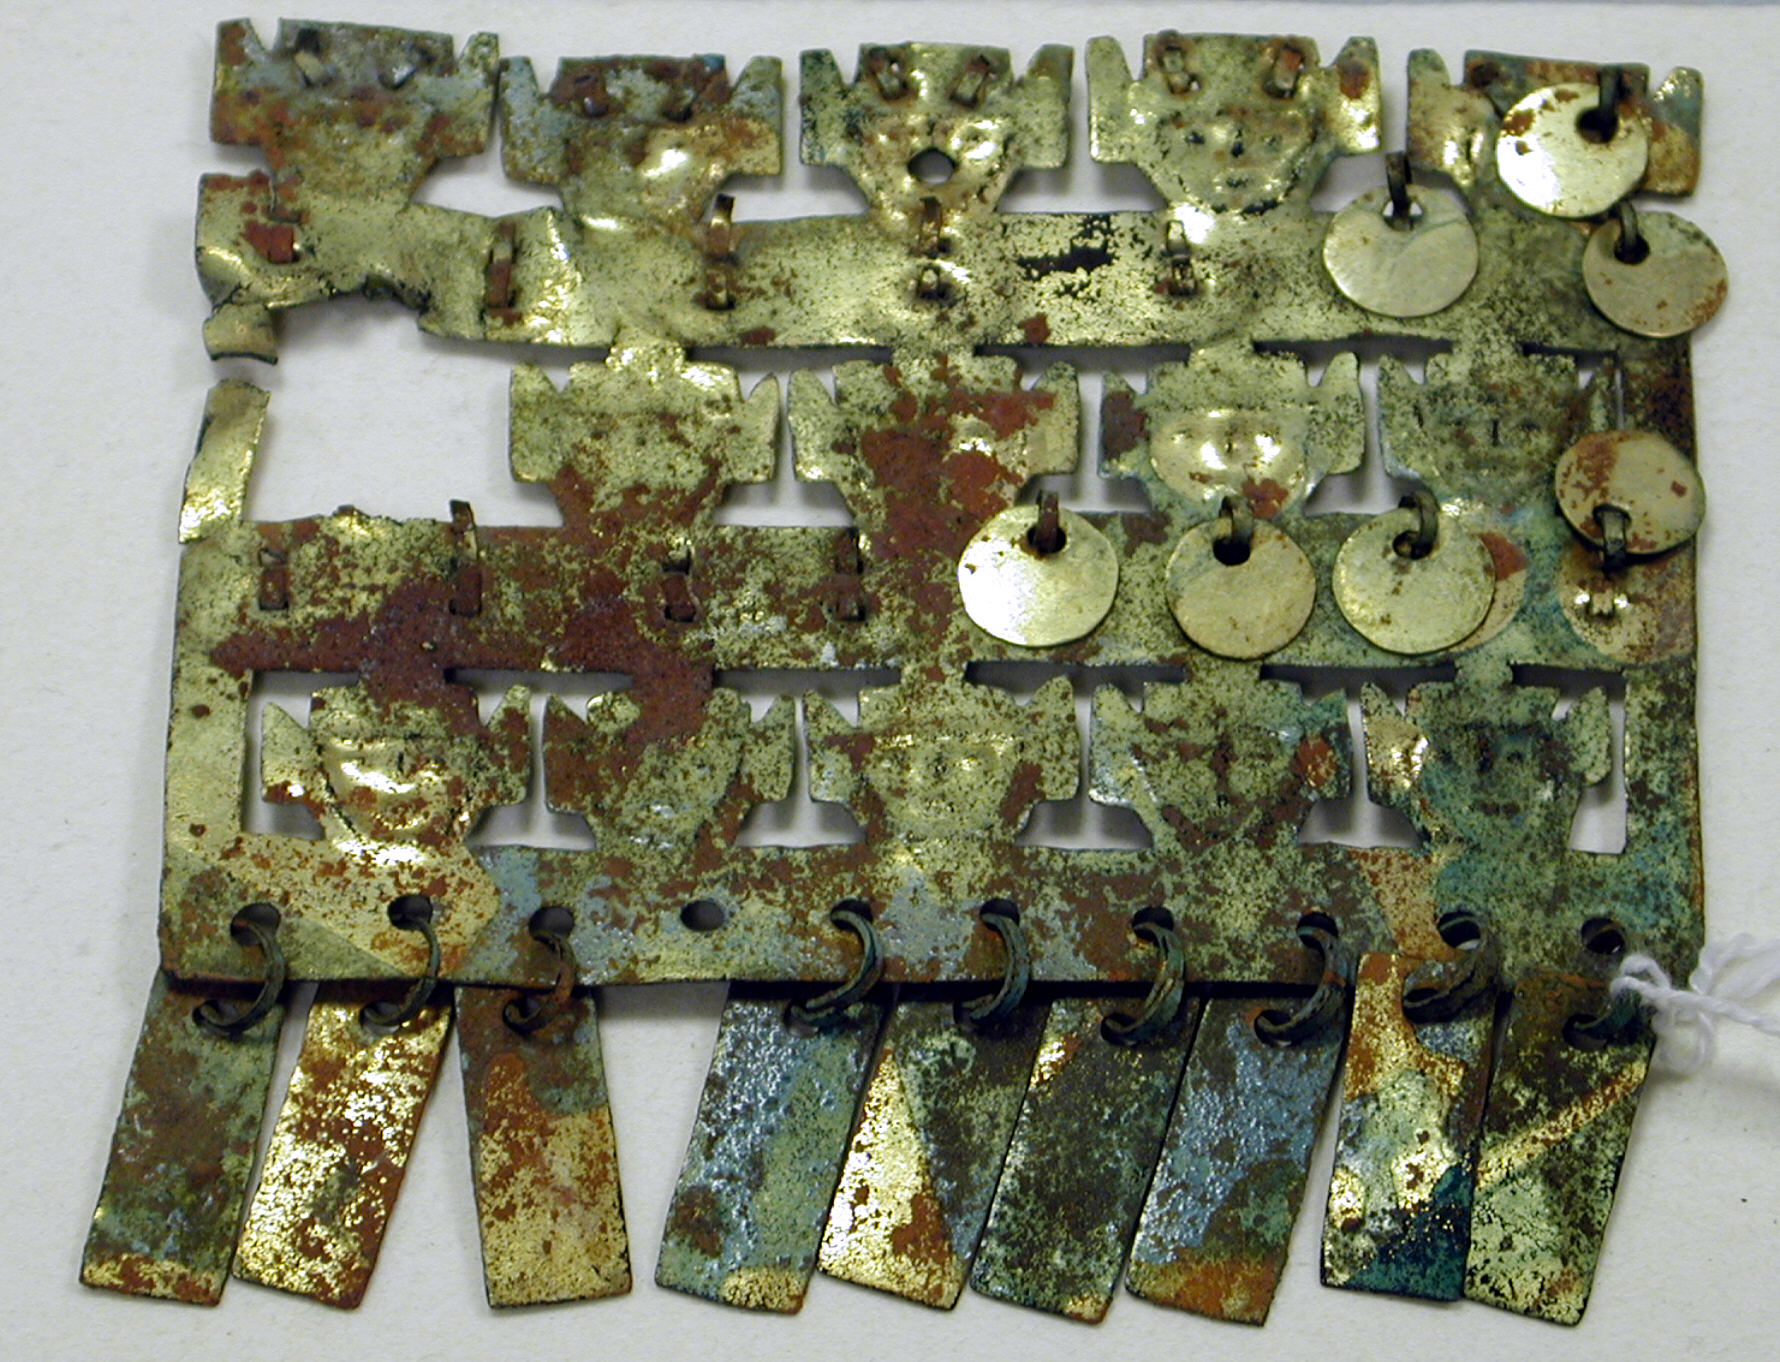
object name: ornament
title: Copper Face Ornament with Dangles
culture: vicús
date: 300 BCE-200 CE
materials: copper, gilt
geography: peru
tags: heads